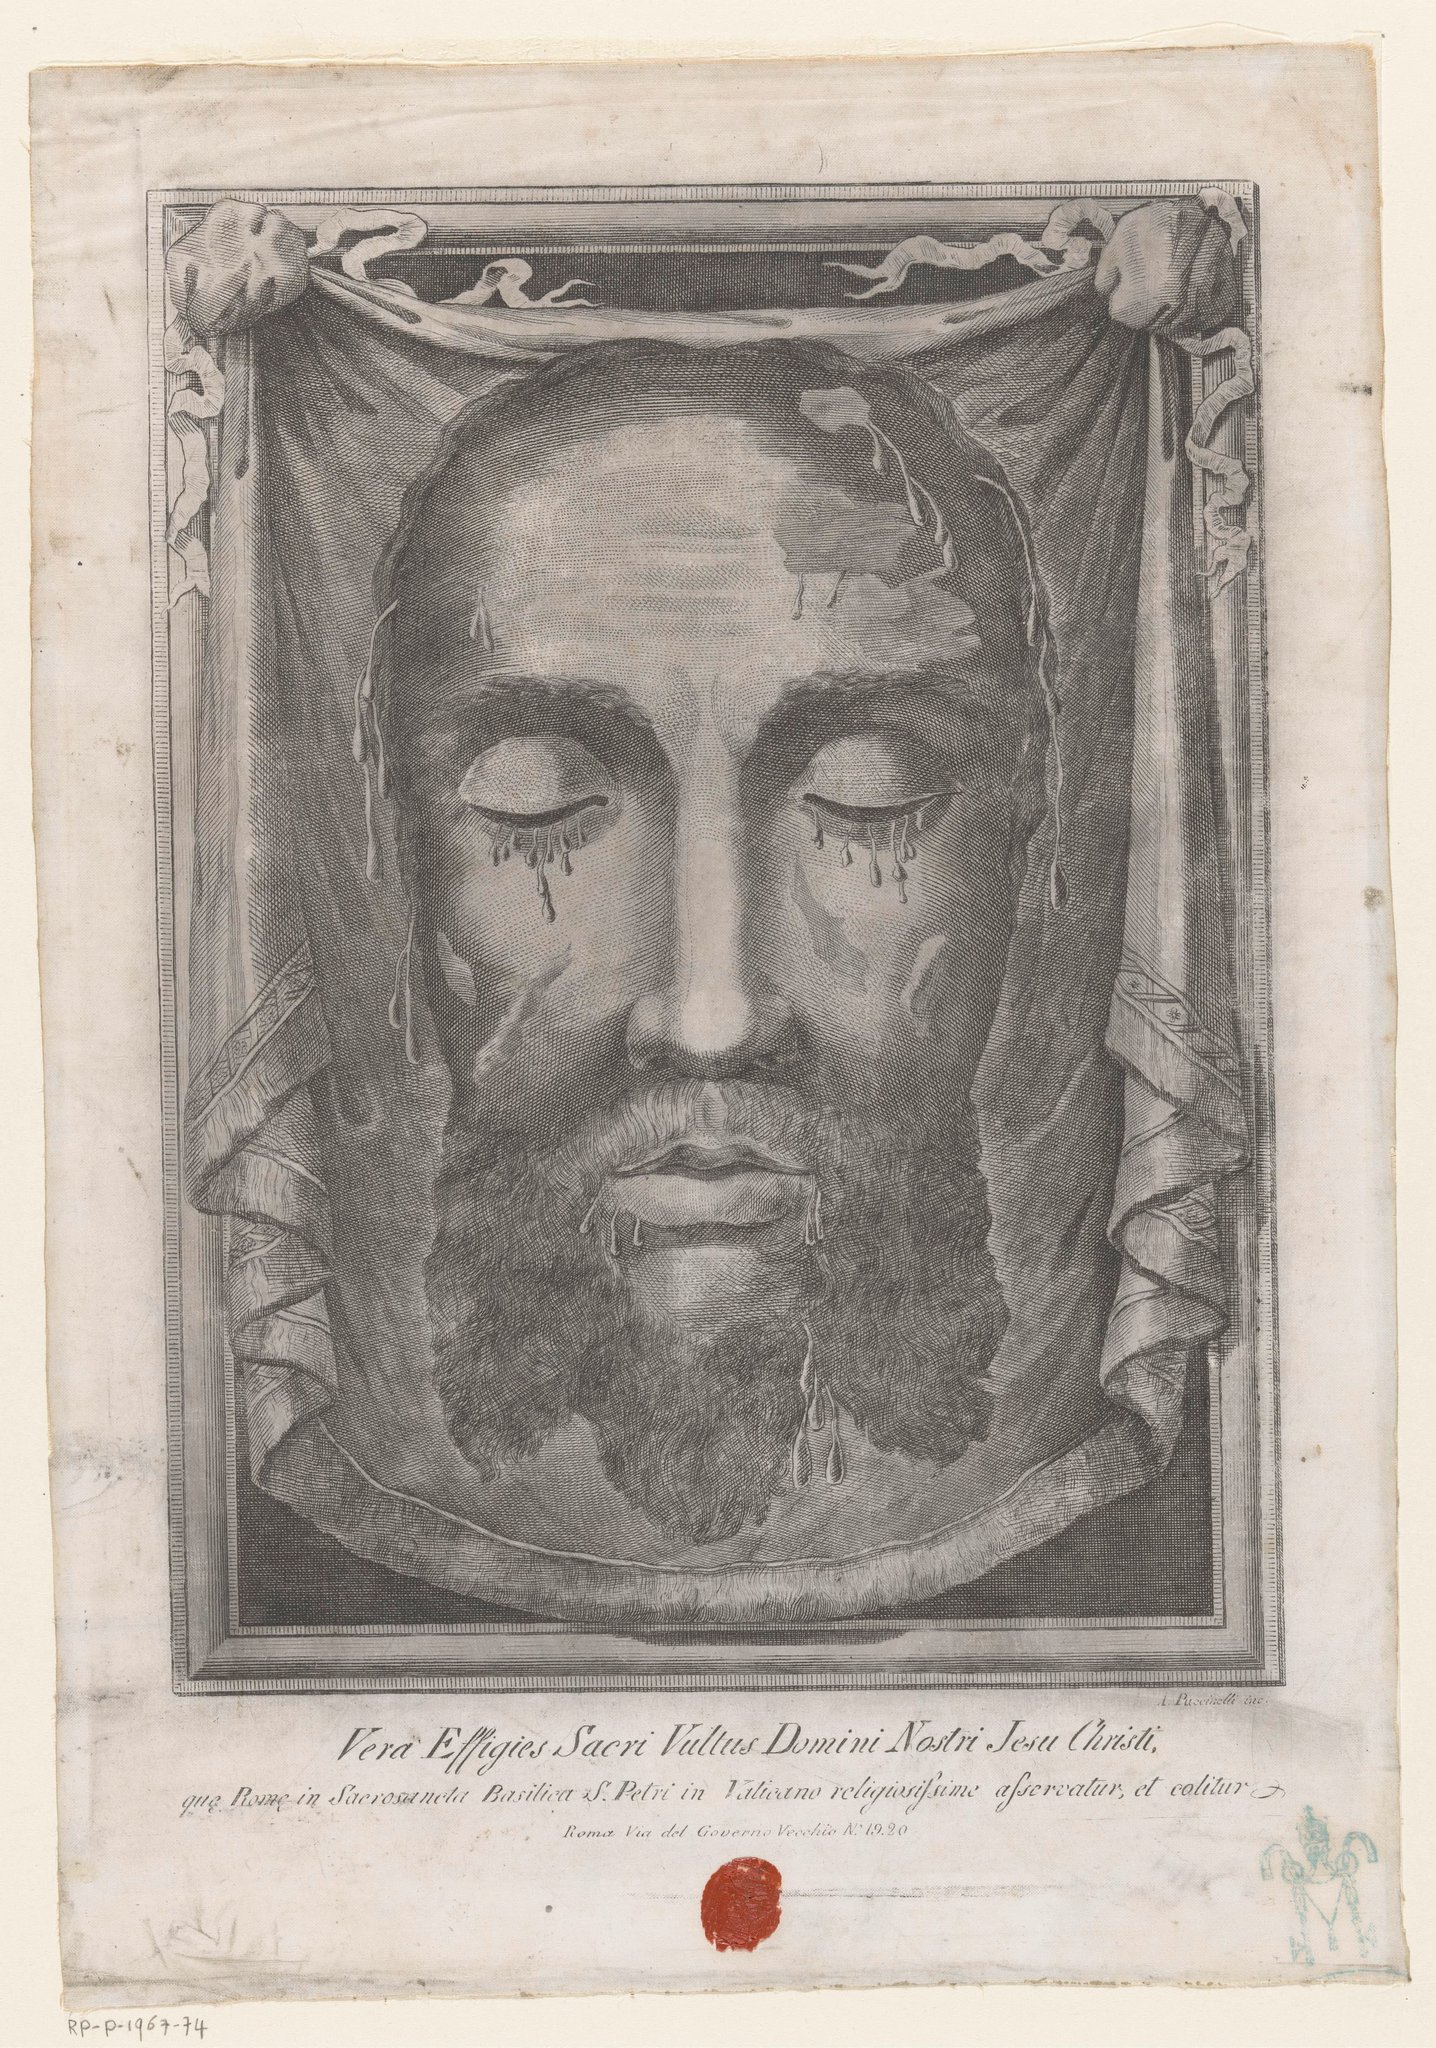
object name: print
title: Zweetdoek van de heilige Veronica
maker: antonio puccinelli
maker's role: print maker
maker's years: 1822-1897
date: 1878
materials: linen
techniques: engraving, etching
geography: rome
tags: veronica; possible attributes: 'sudarium' (veil with the image of christ)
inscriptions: stamp: ‘Gratis’, seal, collector's mark: Lugt 2760, collector's mark: Lugt 2228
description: De zweetdoek (sudarium) van de heilige Veronica met het gezicht van Christus. Veronica wiste tijdens de kruisdraging het zweet van het gezicht van Christus. Op wonderbaarlijke wijze verscheen op het doek een afdruk van zijn gelaat.